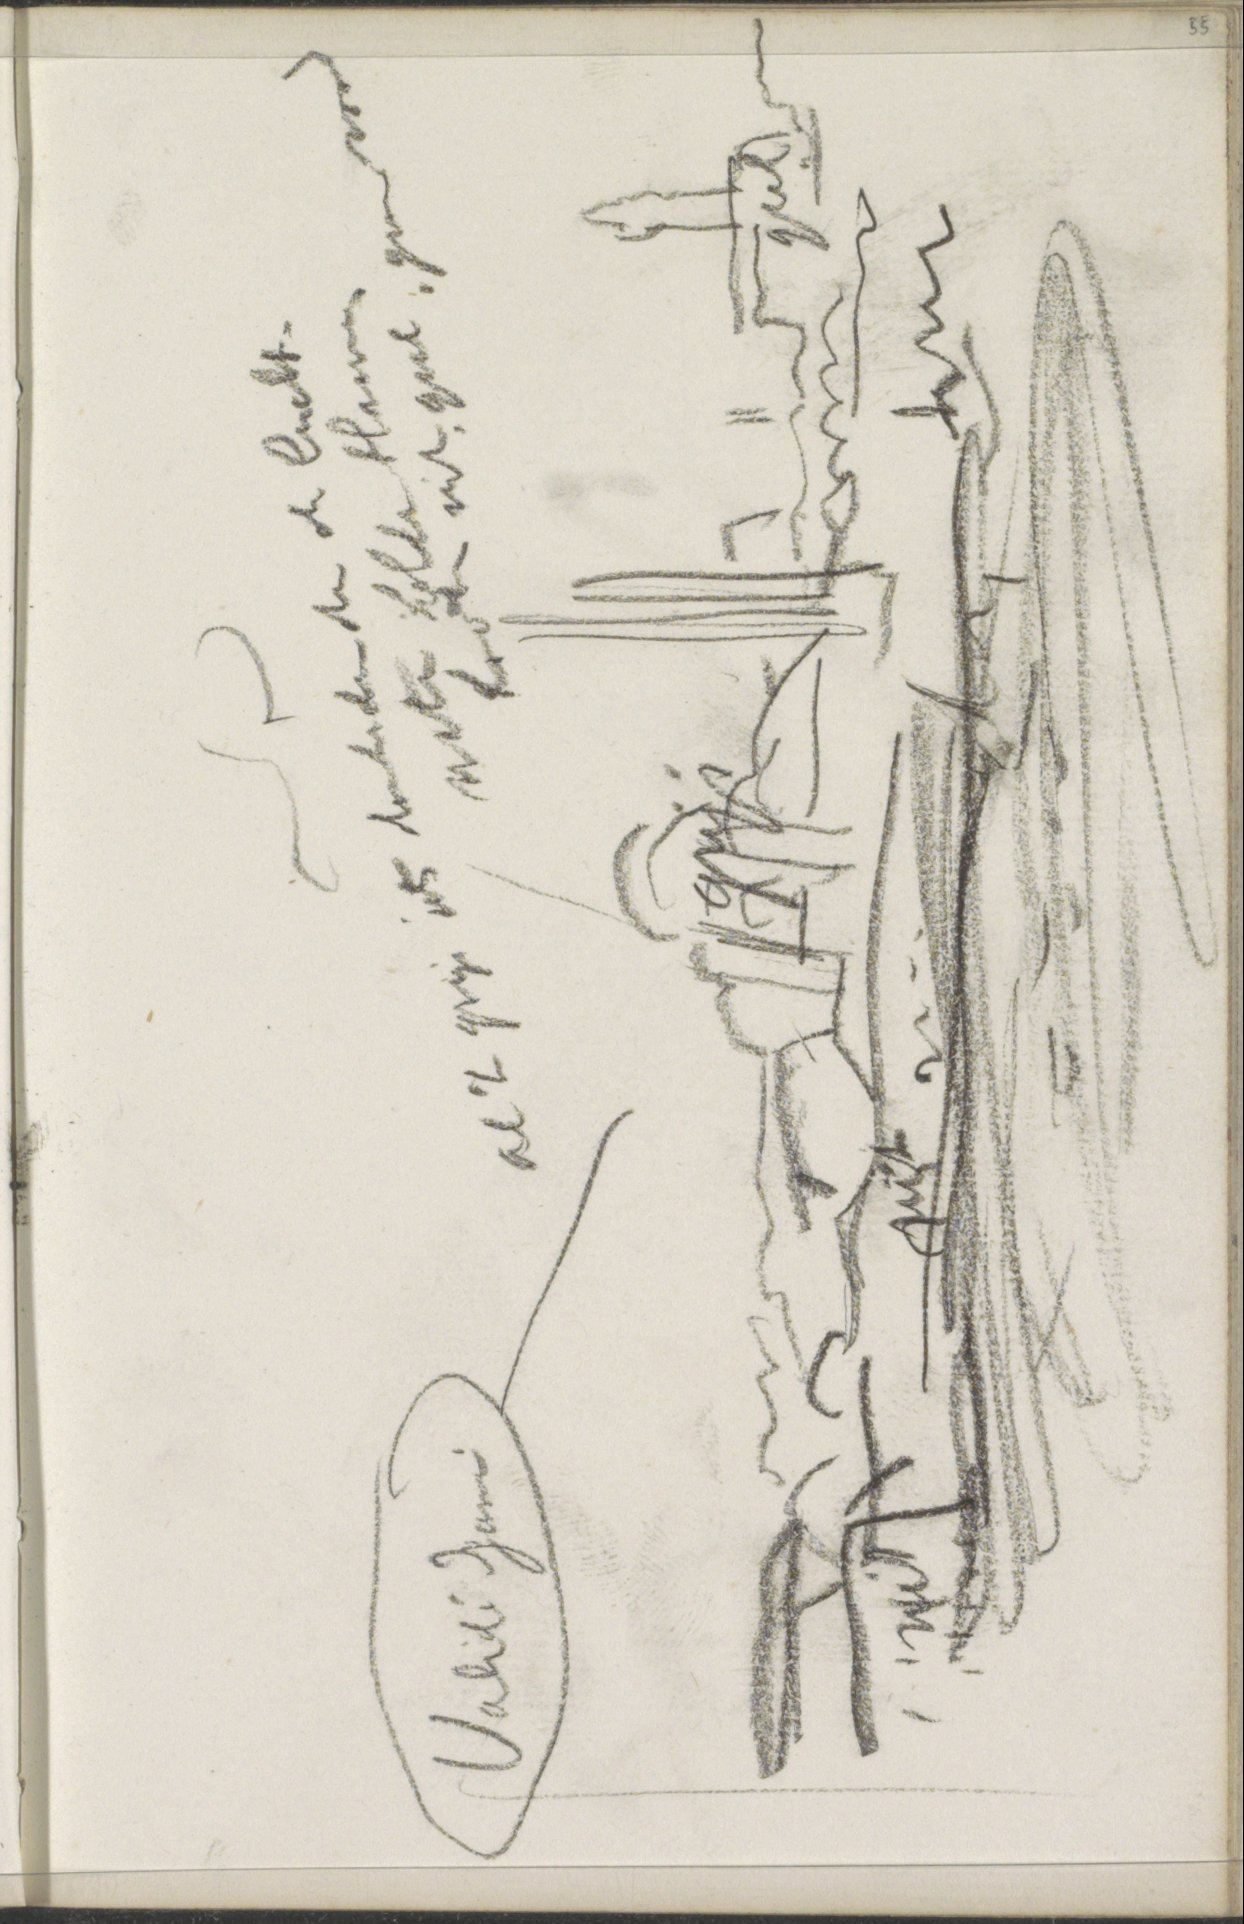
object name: sketchbook leaf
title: Stadsgezicht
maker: marius bauer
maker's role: draughtsman, print maker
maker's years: 1867-1932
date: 1899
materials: chalk, paper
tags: city-view, and landscape with man-made constructions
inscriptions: annotation: ‘Validi Ij[...]’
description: Pagina 55 uit een schetsboek met 42 bladen.